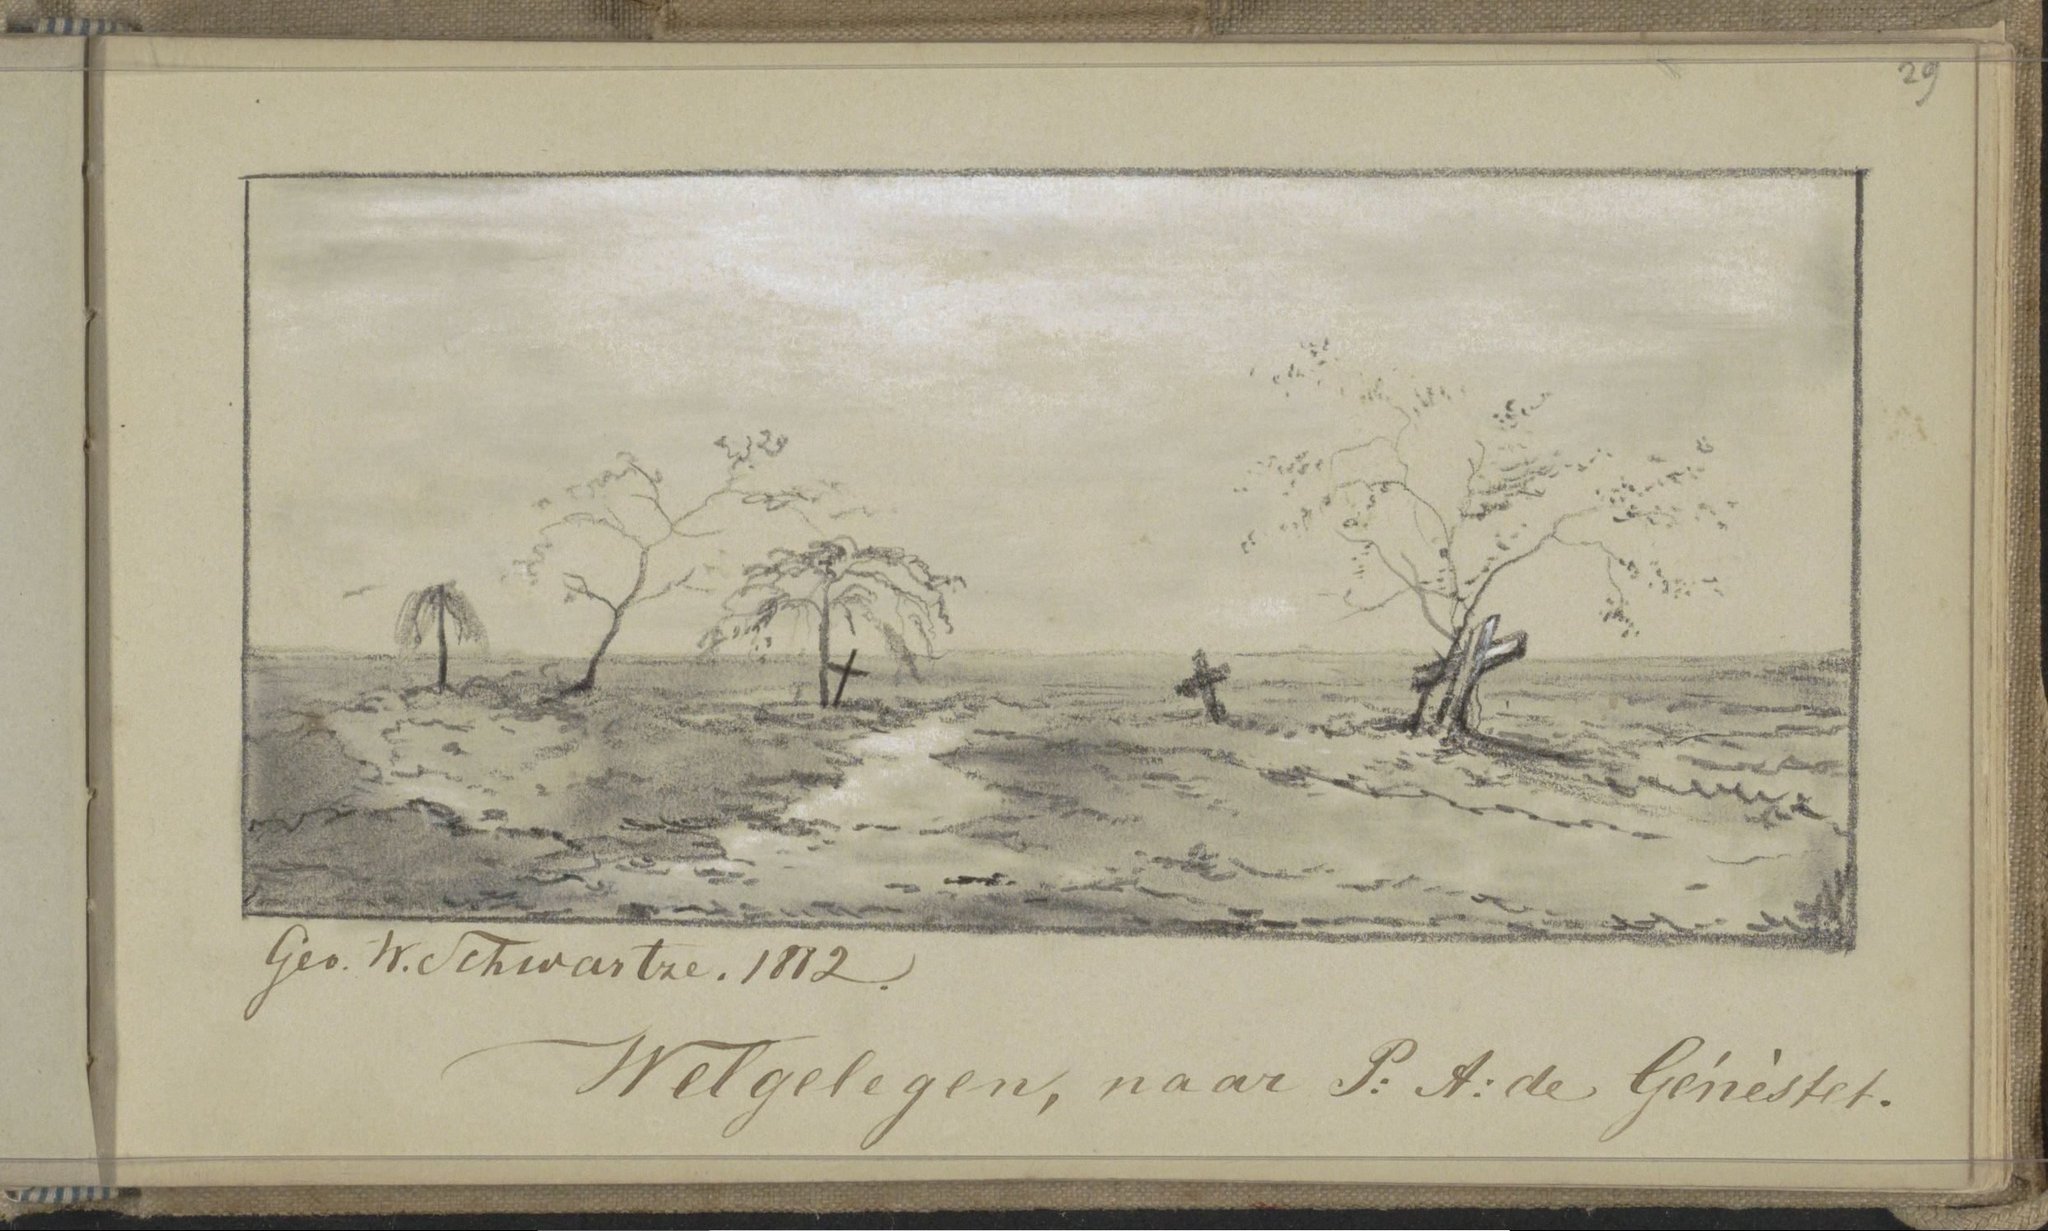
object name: sketchbook leaf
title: Kerkhof bij Welgelegen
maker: george washington schwartze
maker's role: draughtsman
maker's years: 1857-1909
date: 1882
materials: chalk, paper, pencil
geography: delft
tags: churchyard, cemetery, delft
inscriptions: title: ‘Welgelegen, naar P:A: de Génestet.’, signature and date: ‘G.W.Schwartze. 1882.’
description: Schets gebaseerd op het gedicht 'Welgelegen' van P.A. de Génestet over zijn domineeswoning bij Delft die naast een kerkhof was gelegen.